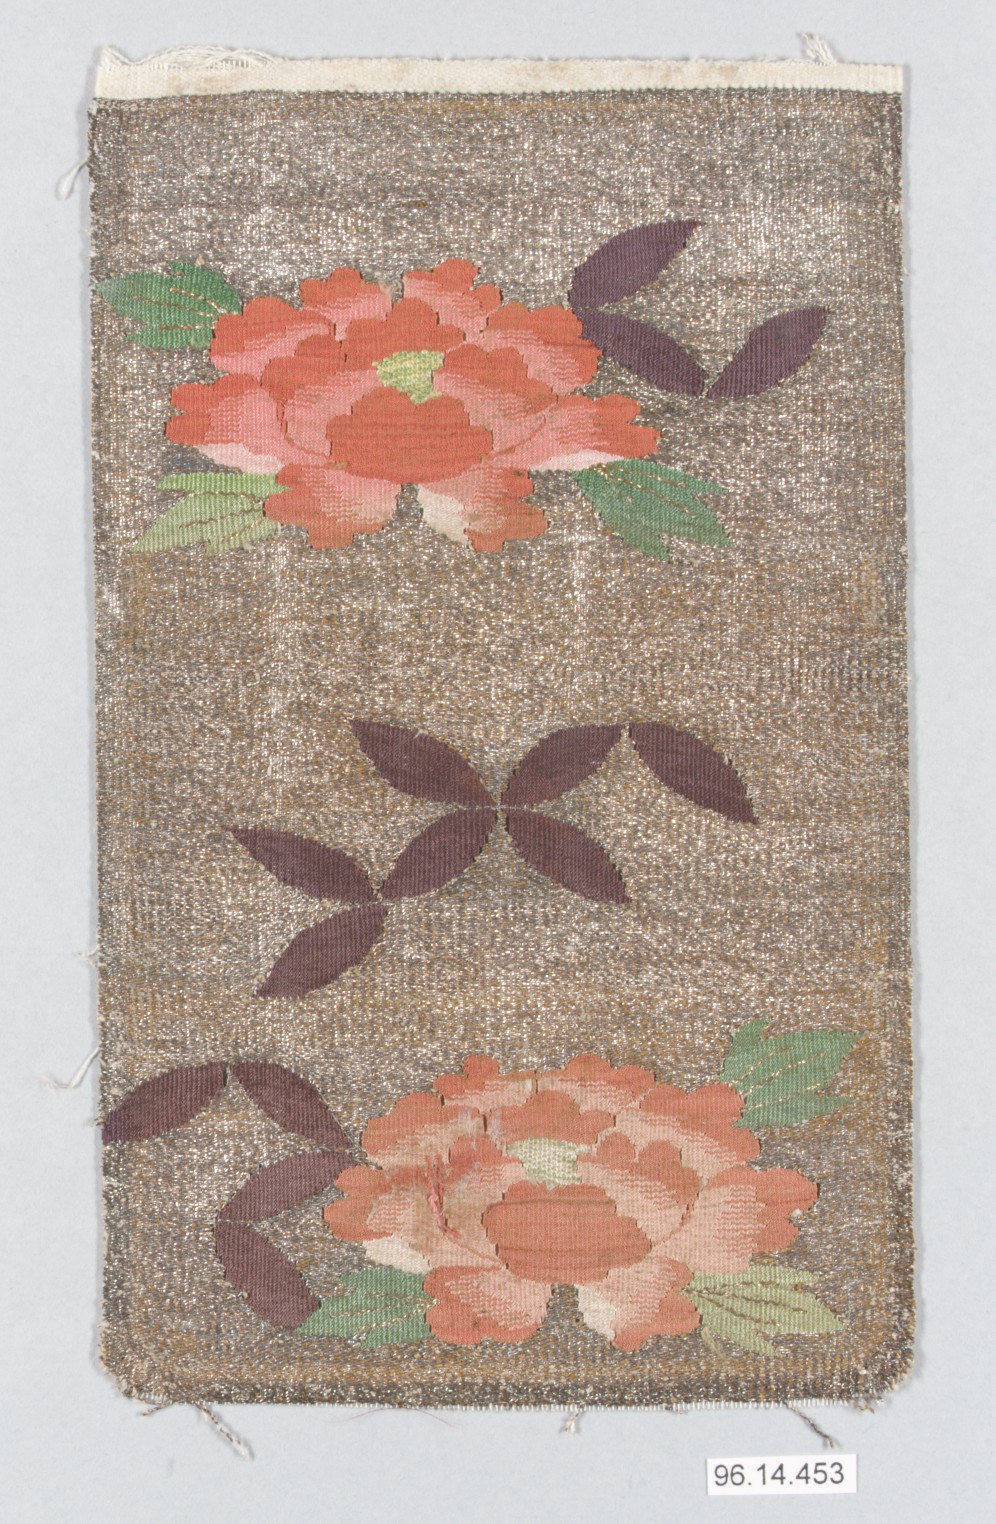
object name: piece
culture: japanese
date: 1701-1900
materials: silk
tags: leaves